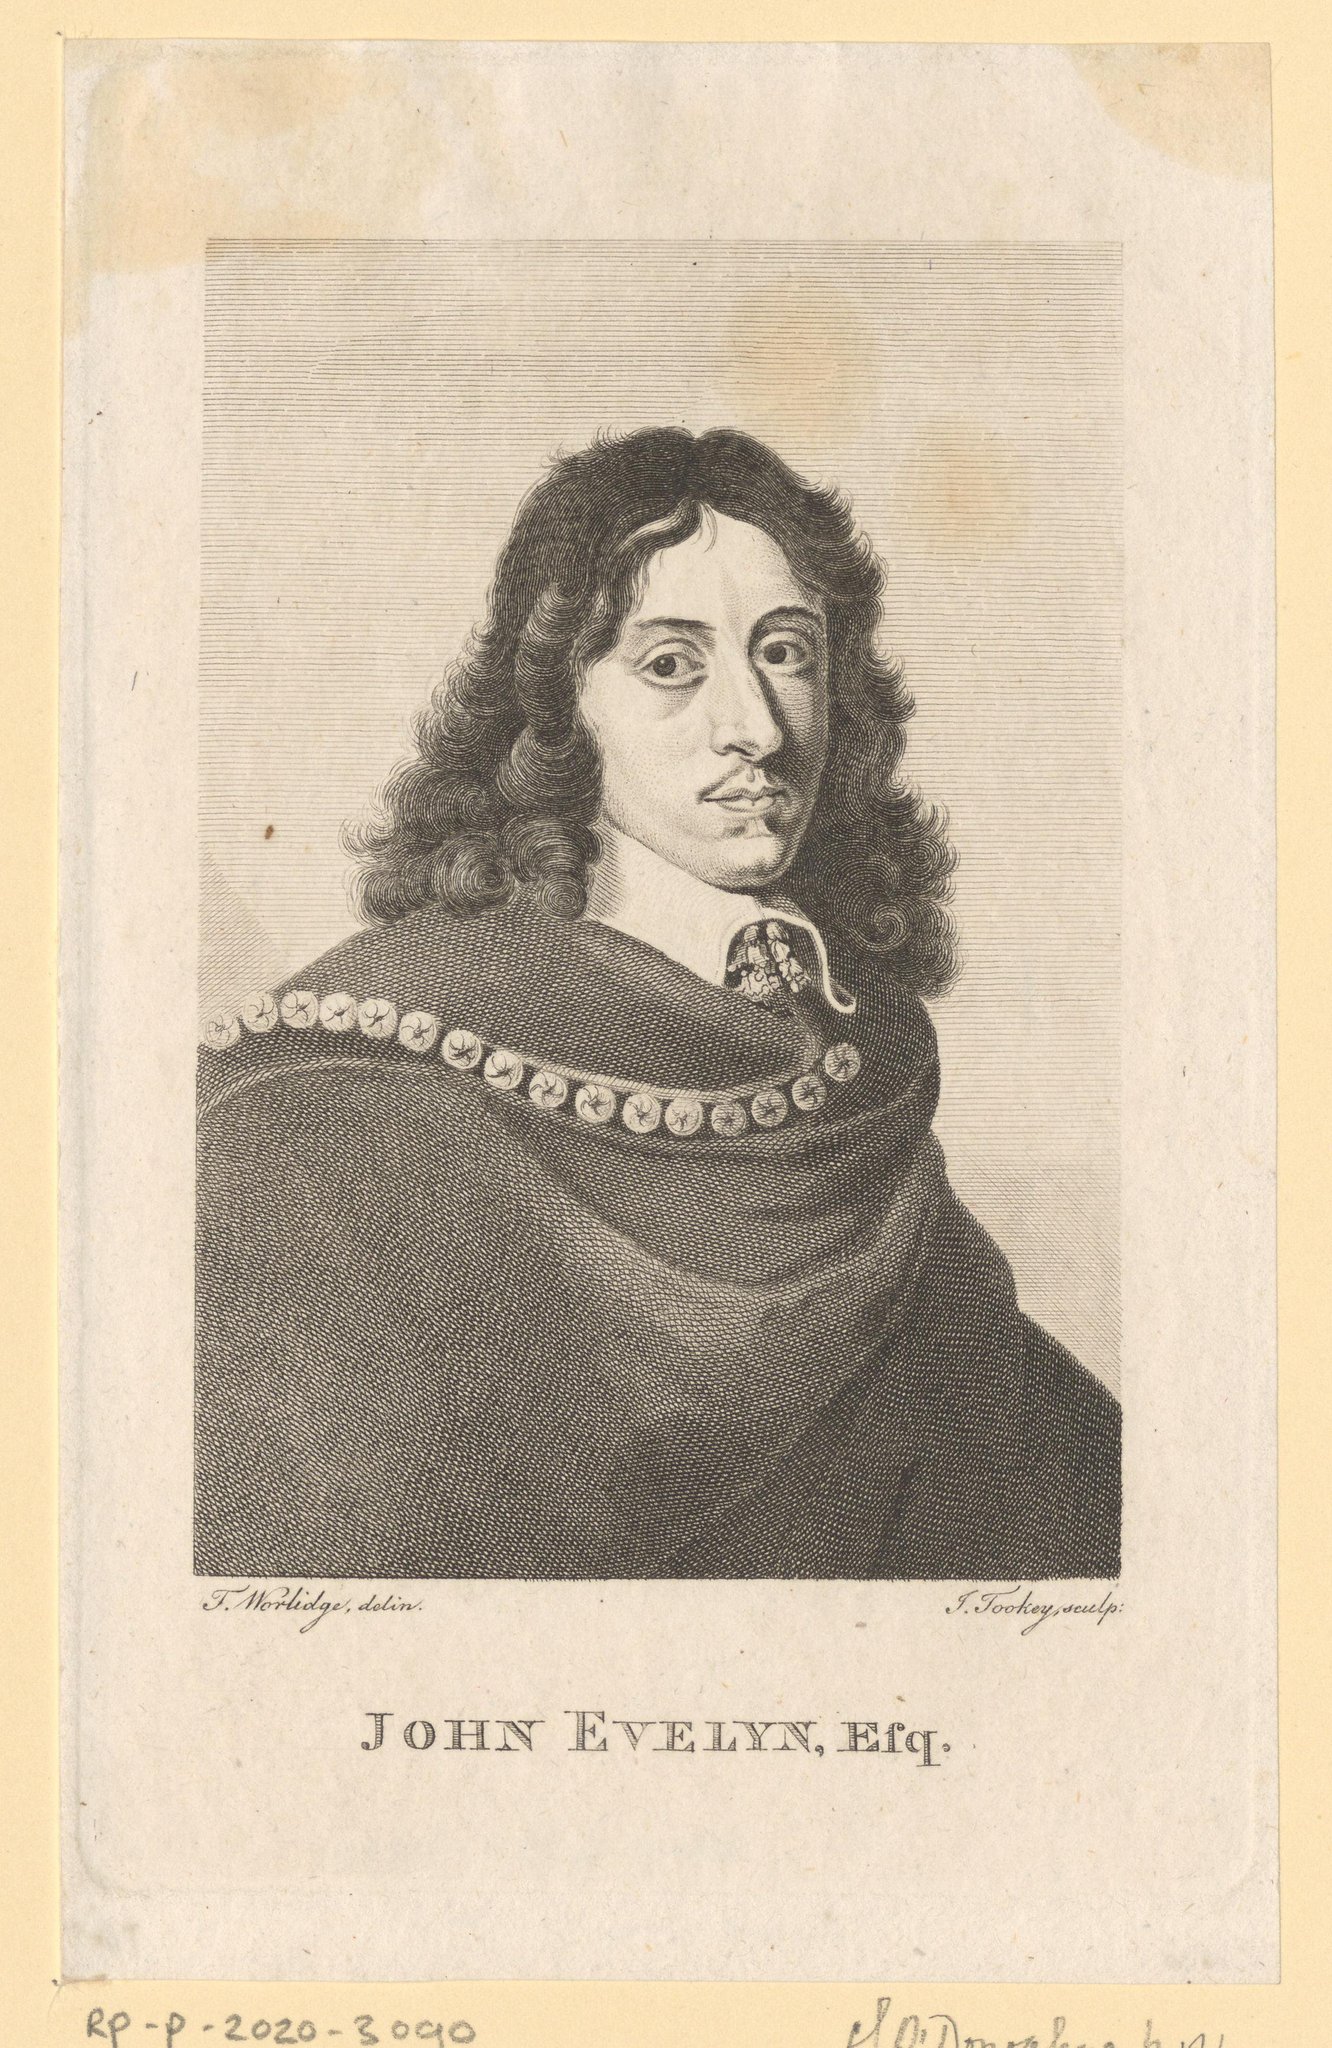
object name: print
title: Portret van John Evelyn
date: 1800-1830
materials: paper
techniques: etching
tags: print maker, john evelyn, historical persons, portrait of a writer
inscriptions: inscription: ‘n. 1620 Engel[...]s Numismaticus +1705/6’